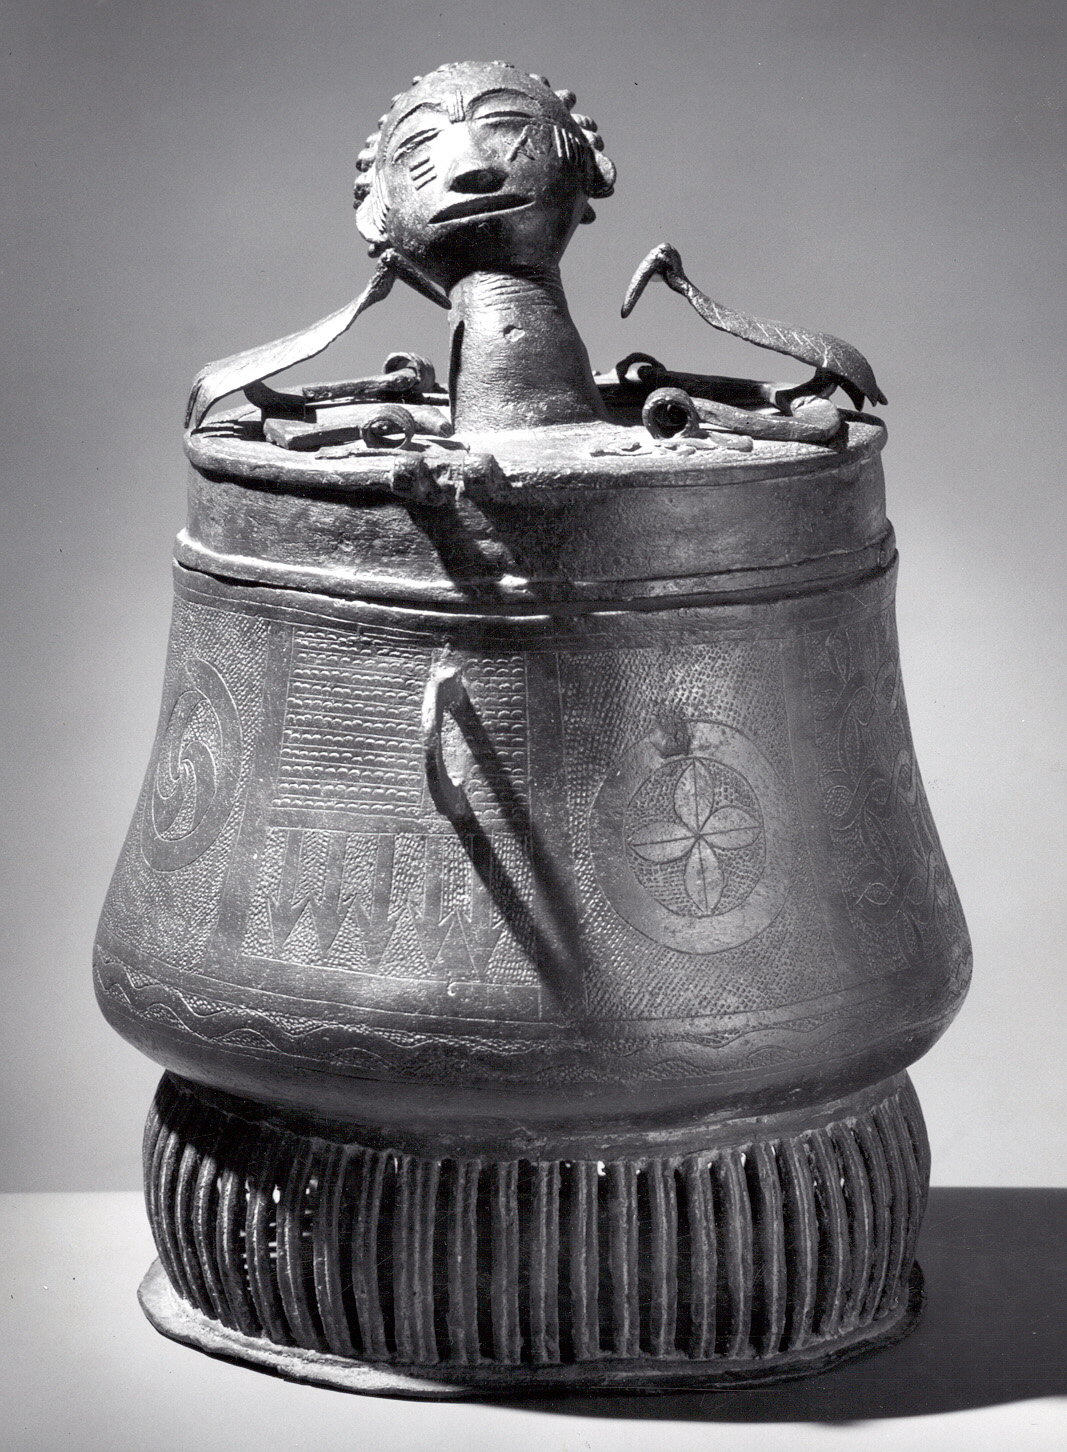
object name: vessel with lid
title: Container (Kuduo)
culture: akan peoples, asante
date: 1701-1900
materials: brass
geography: ghana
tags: heads